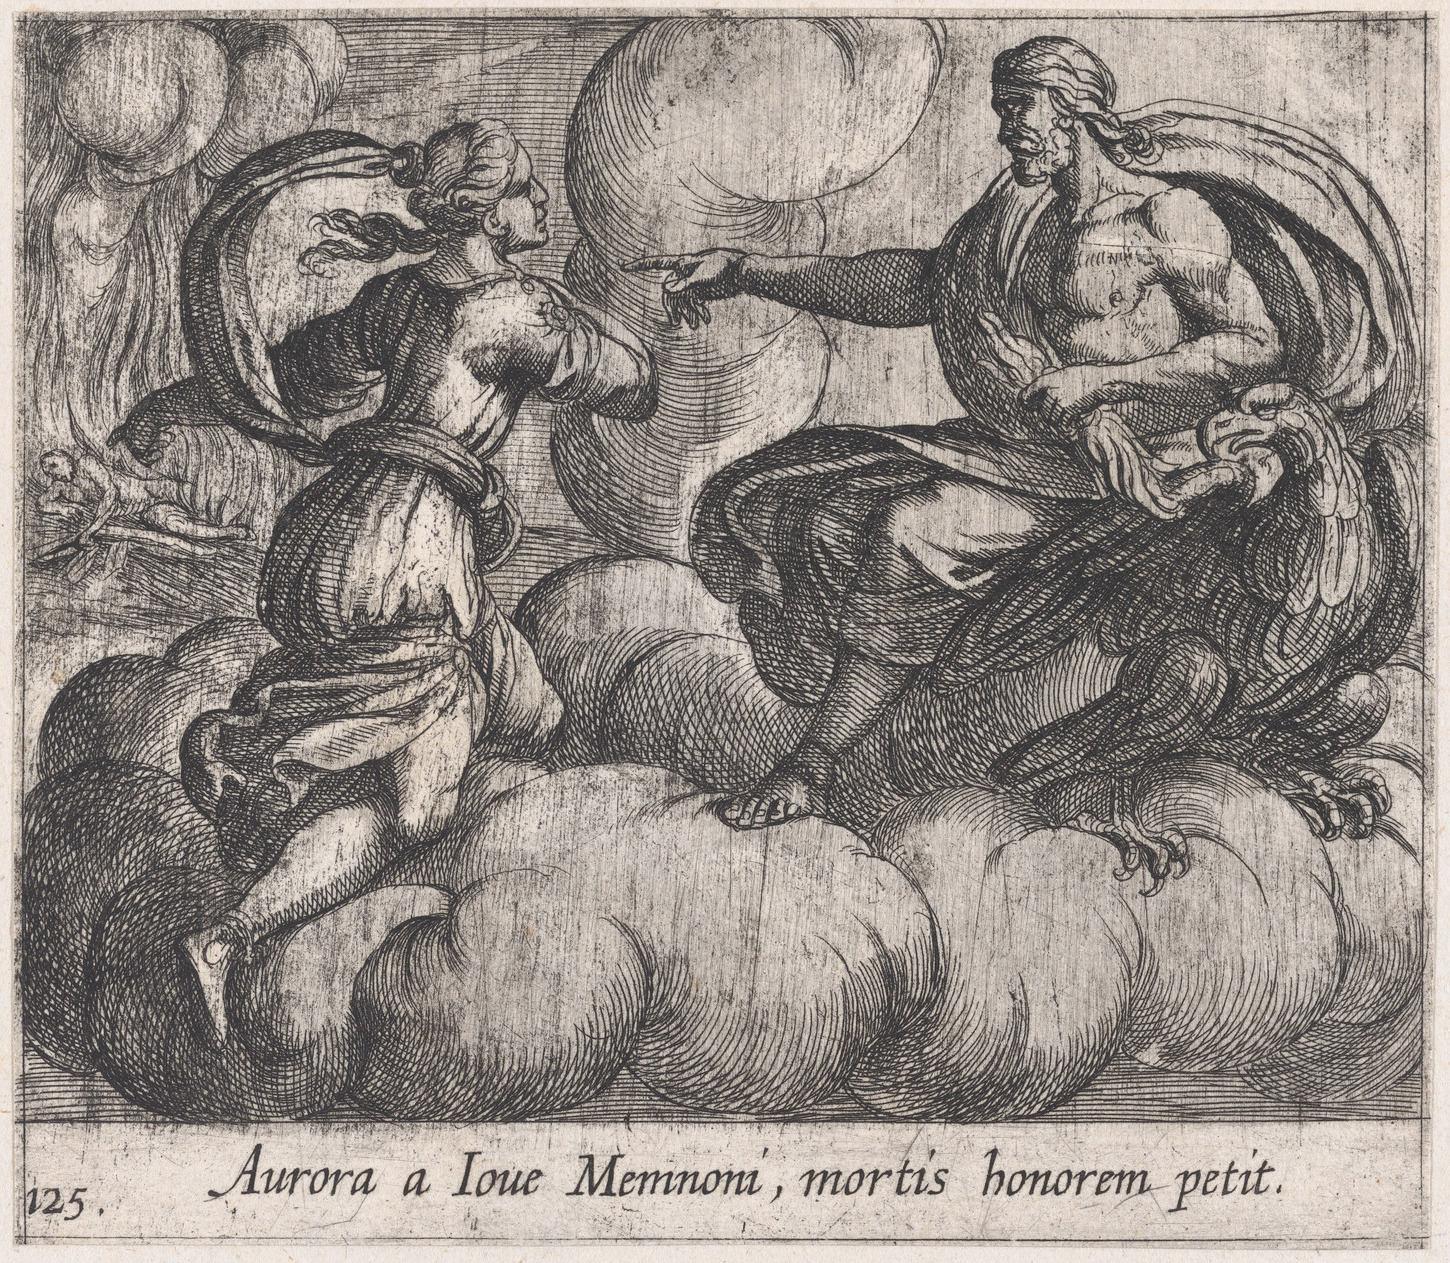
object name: print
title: Plate 125: Aurora Asking Jupiter to Honor Memnon (Aurora a Iove Memnoni, mortis honorem petit), from Ovid's 'Metamorphoses'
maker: antonio tempesta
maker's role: artist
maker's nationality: italian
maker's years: 1555-1630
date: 1606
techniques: etching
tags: eagles,jupiter